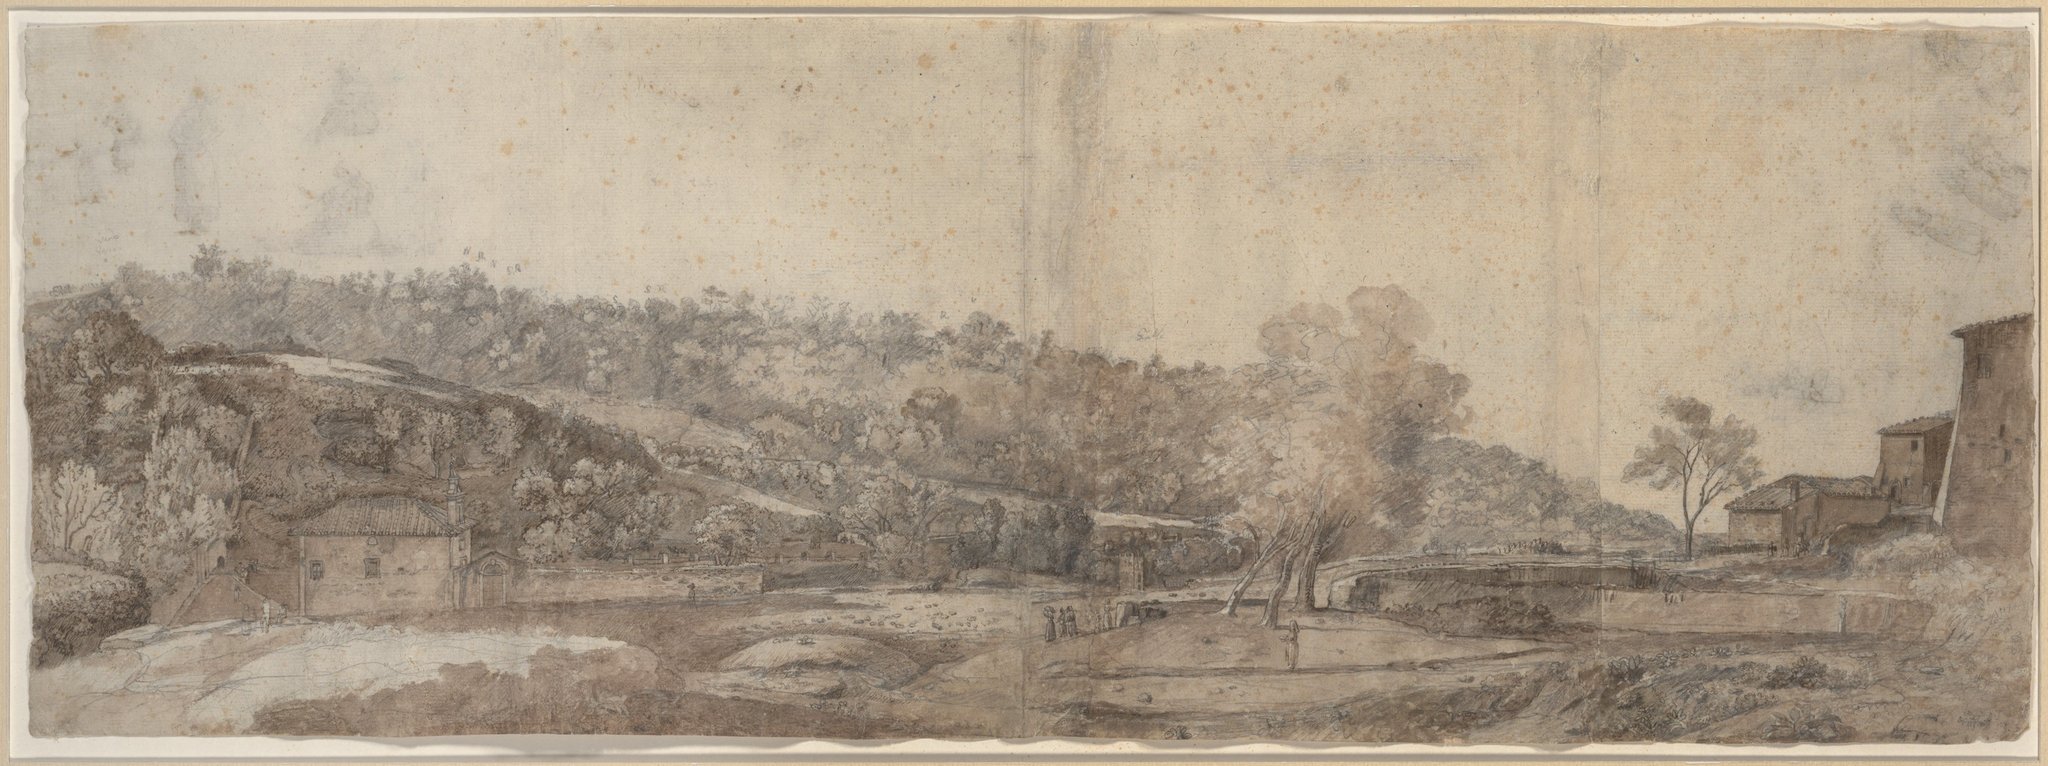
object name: drawing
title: Italian Landscape with Buildings and Figures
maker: nicolas didier boguet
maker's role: artist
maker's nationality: french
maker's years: 1755-1839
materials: chalk, ink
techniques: brush, pen, wash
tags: buildings,landscapes,trees